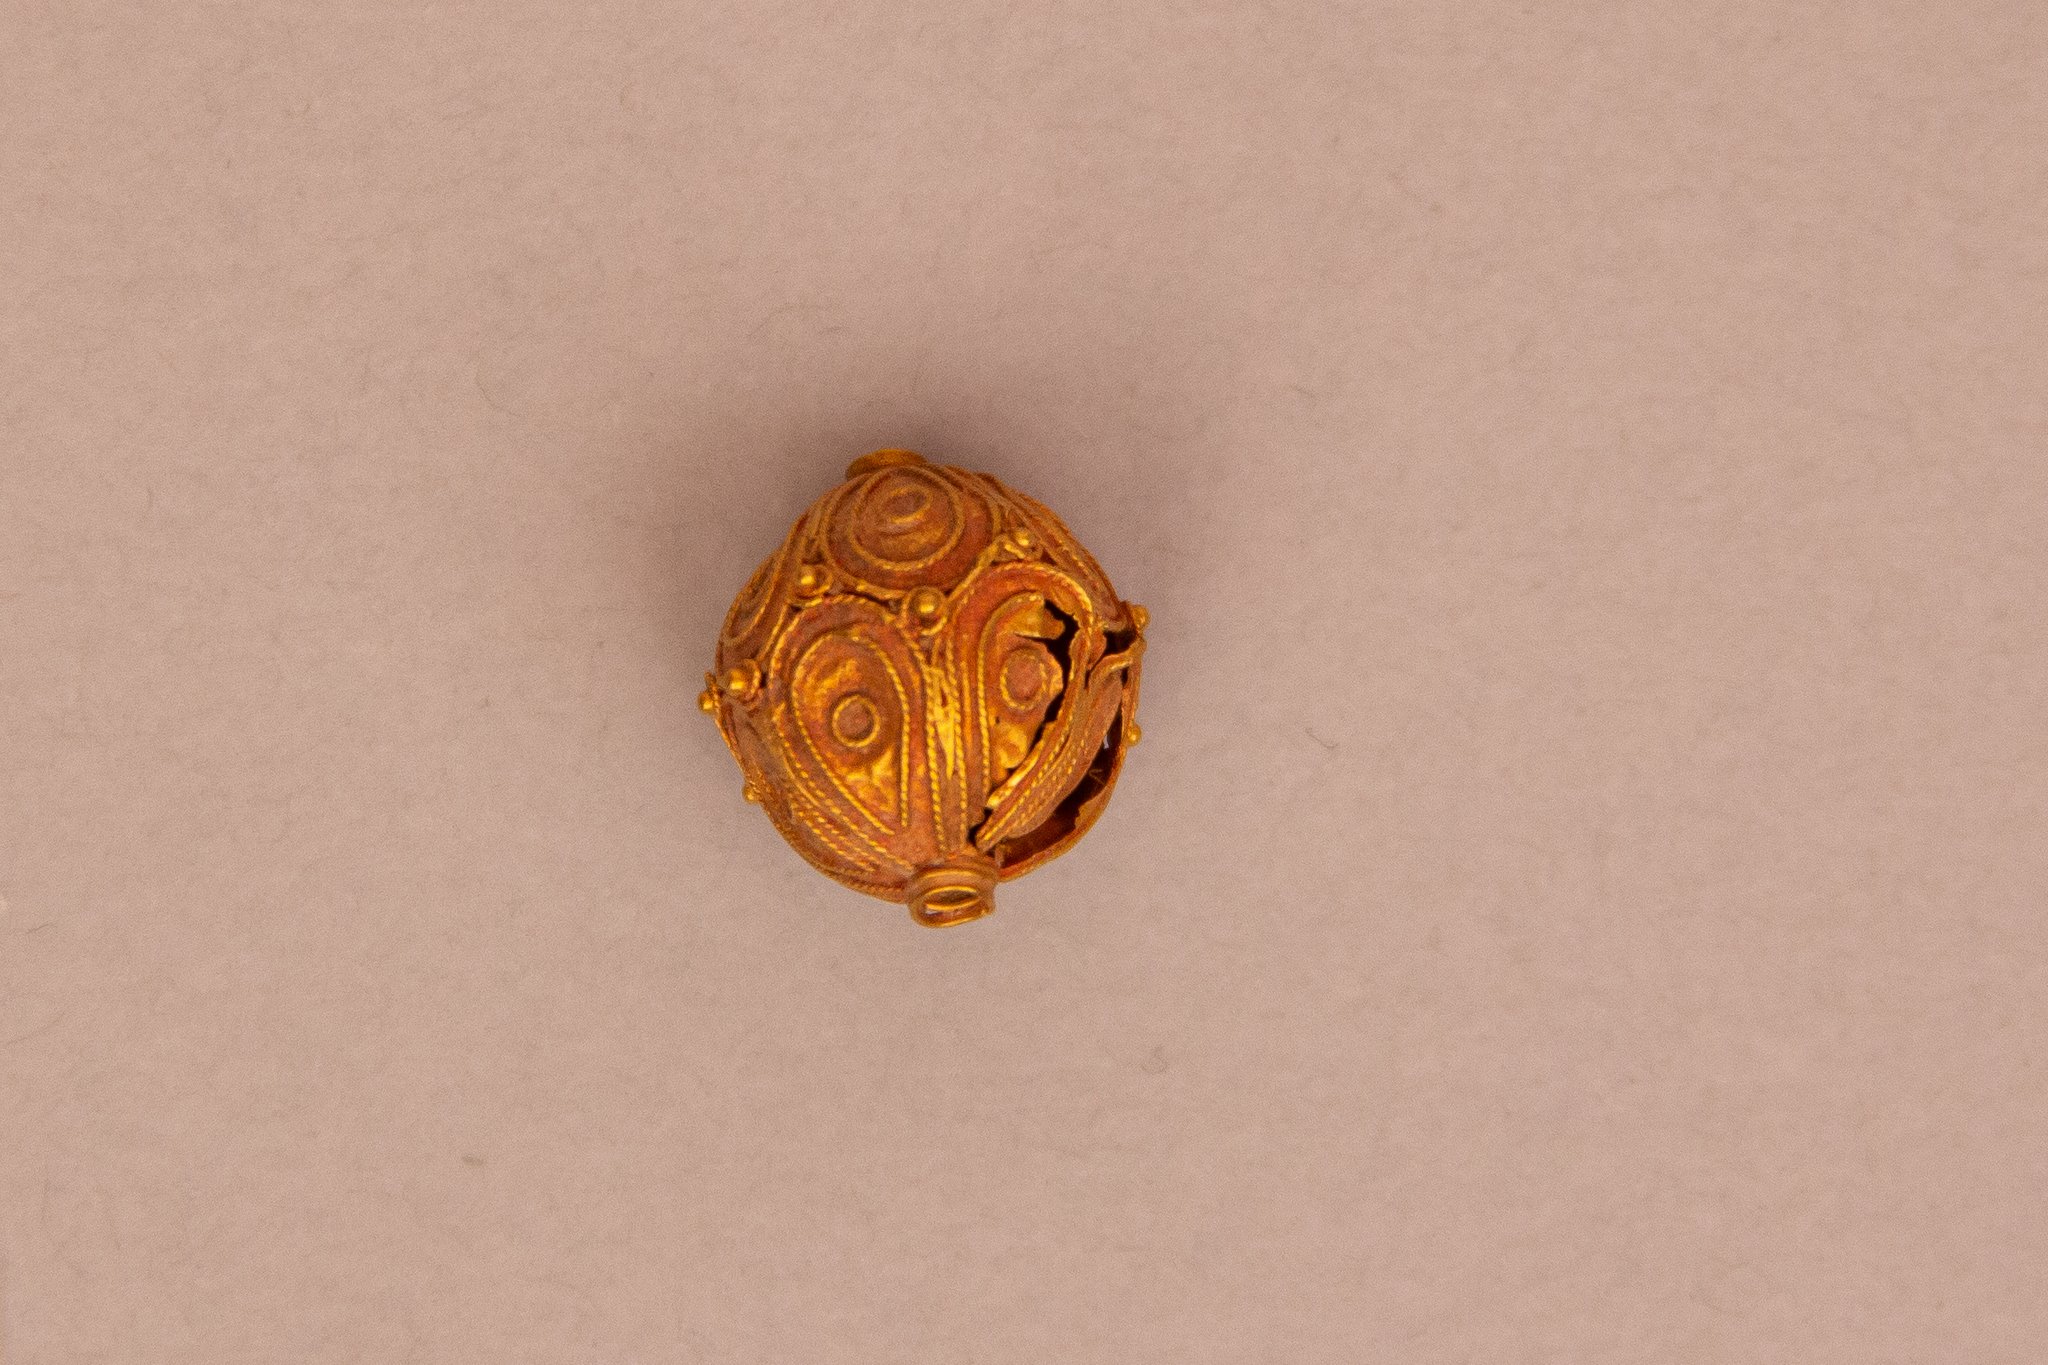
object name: bead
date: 1001-1100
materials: gold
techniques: filigree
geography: egypt or syria